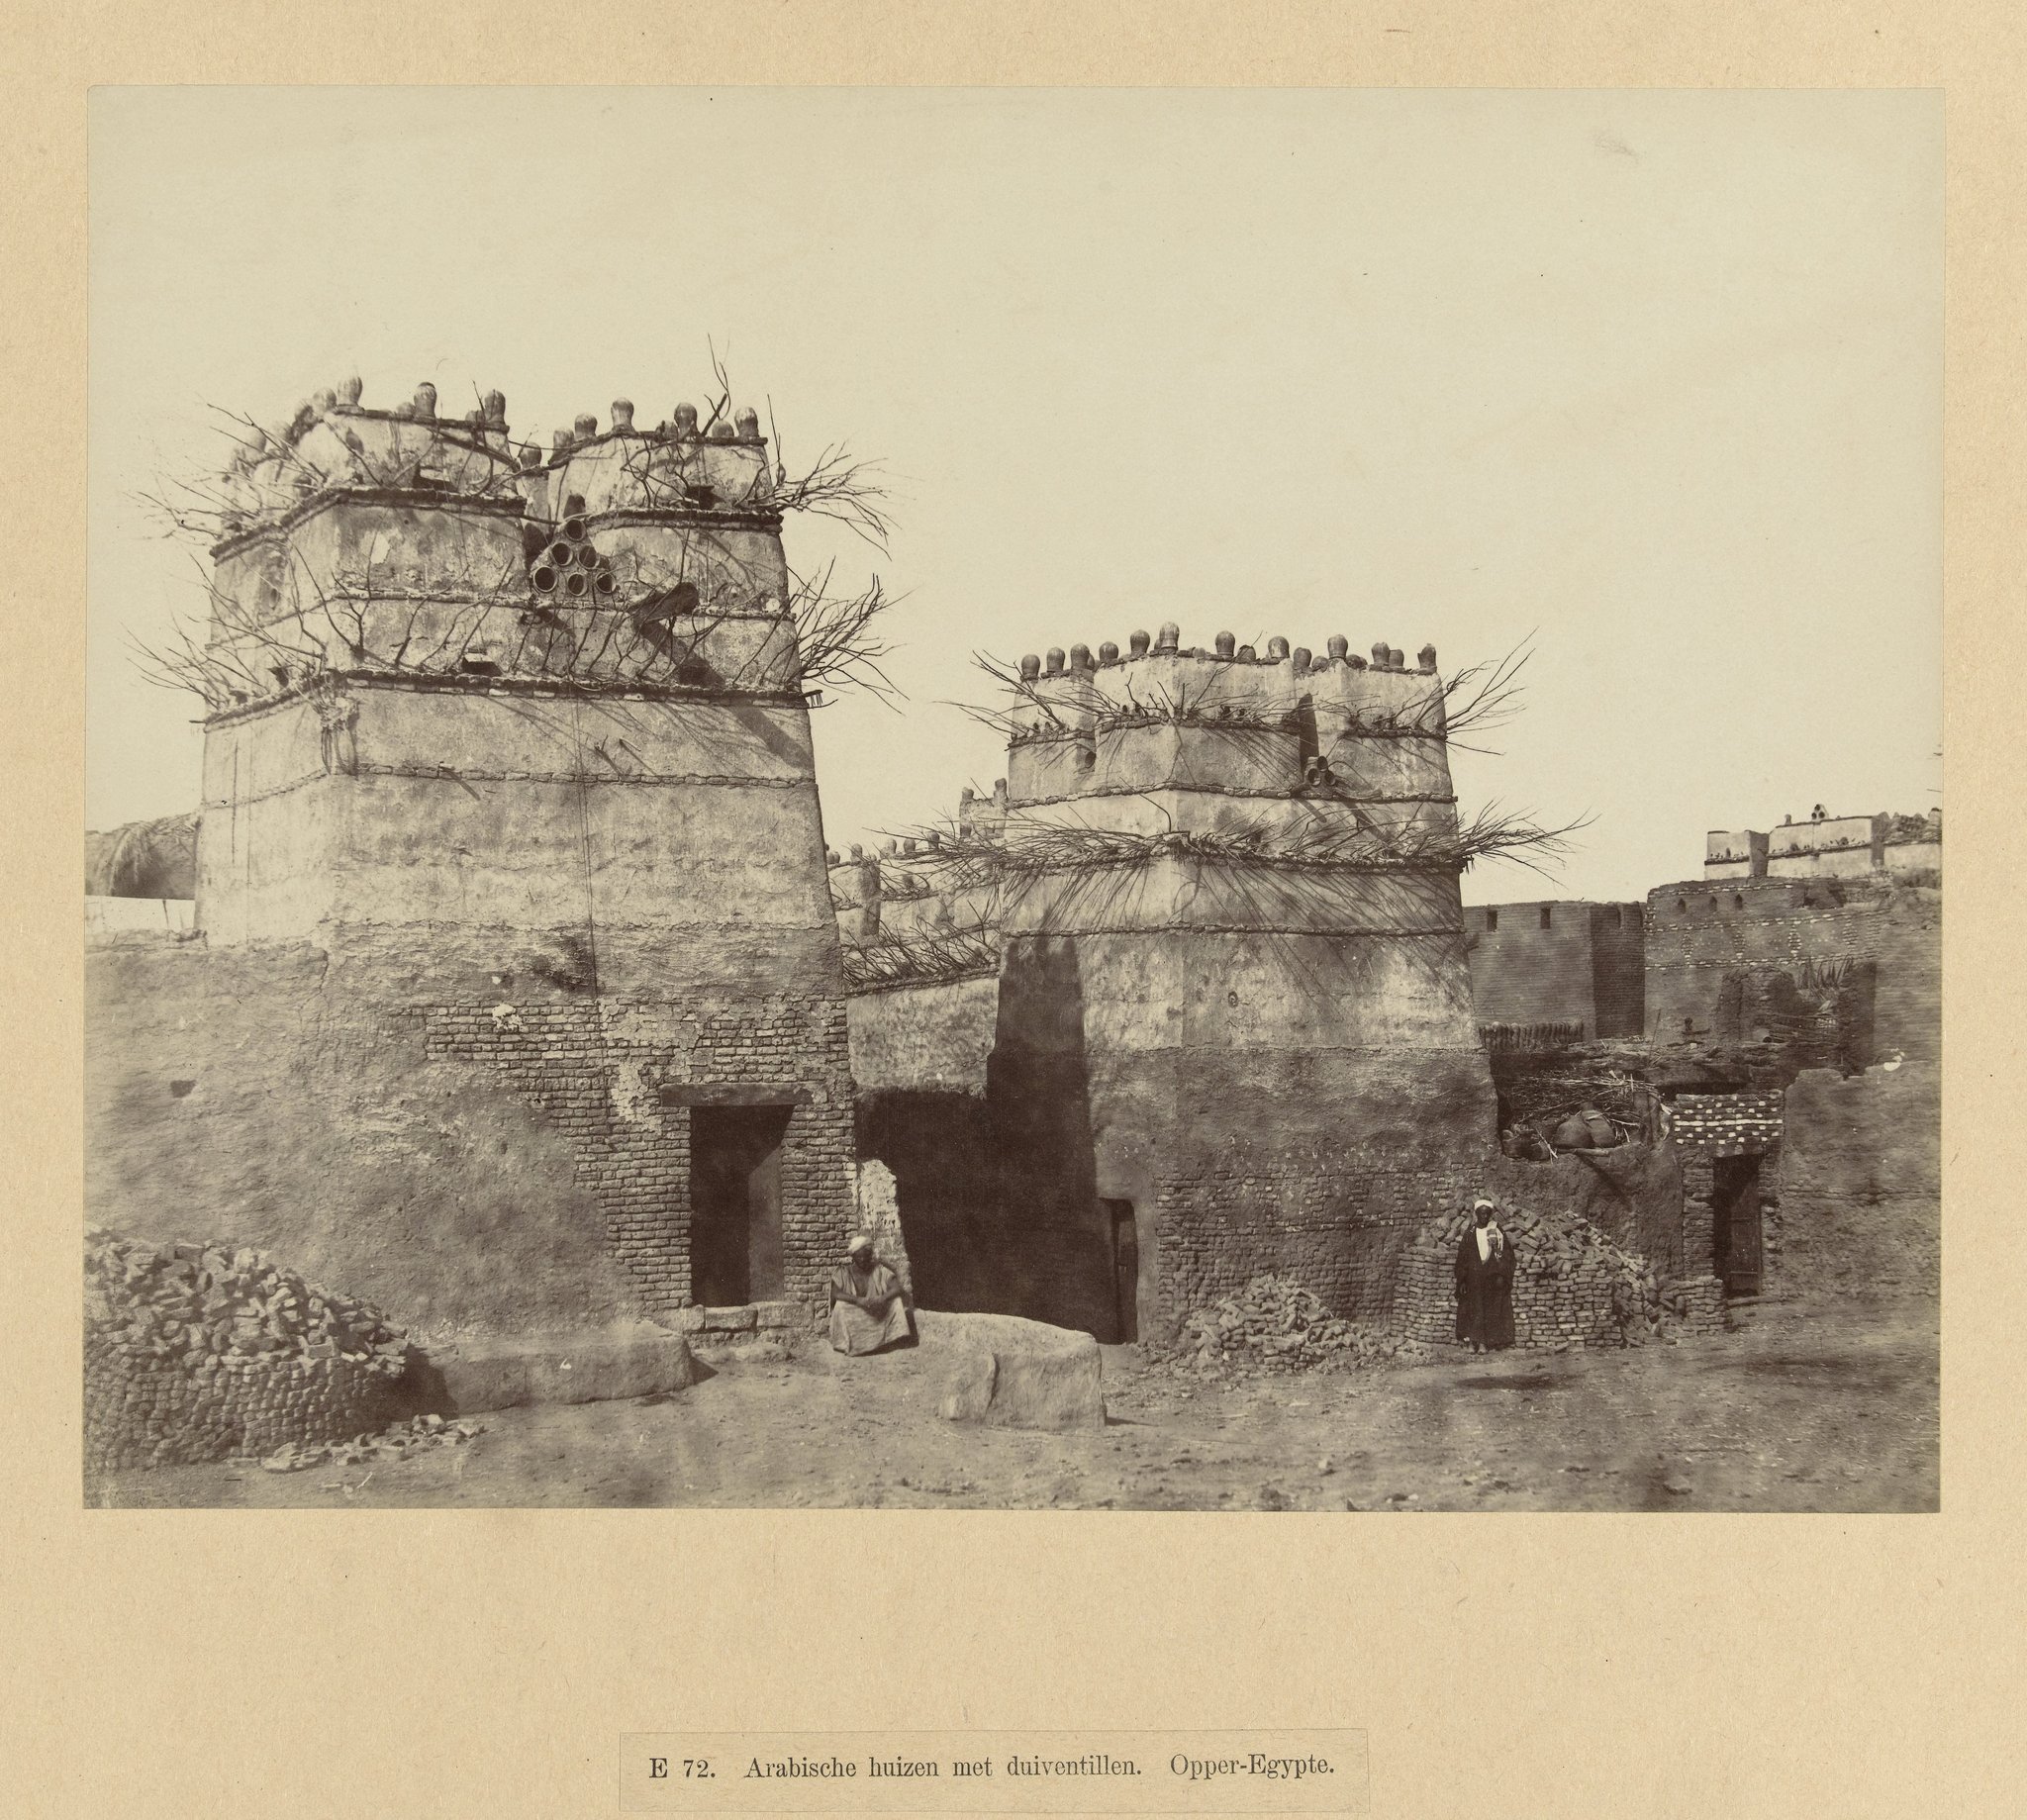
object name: photograph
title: Rechthoekige woningen met uitstekende rieten delen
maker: Anonymous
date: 1890-1895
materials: cardboard, paper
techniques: albumen print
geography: egypt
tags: dove-cote, exterior ~ representation of a building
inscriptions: title: ‘E 72. Arabische huizen met duiventillen. Opper-Egypte.’, stamp: ‘GEMEENTELIJKE BIBLIOTHEEK/ ROTTERDAM’, check stamp: ‘Bristol/ L.M.’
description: Onderdeel van een groep door fotograaf Richard Polak op reis verzamelde foto’s. Deze foto is samen met andere op zijn reizen verzamelde foto's tentoongesteld bij de Rotterdamsche Kunstkring (1895), Arti en Amicitiae te Amsterdam (1897-1898?) en Societeit 't Collegie te Kampen (datum vooralsnog onbekend).